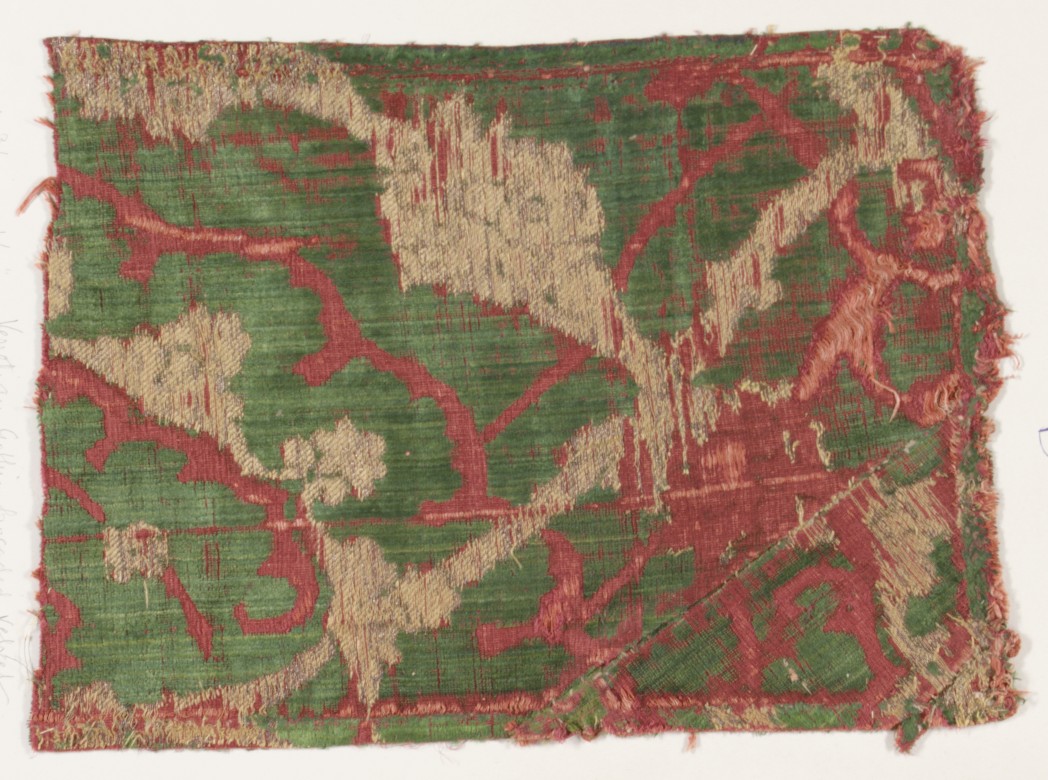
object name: fragment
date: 1501-1533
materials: metal thread, silk